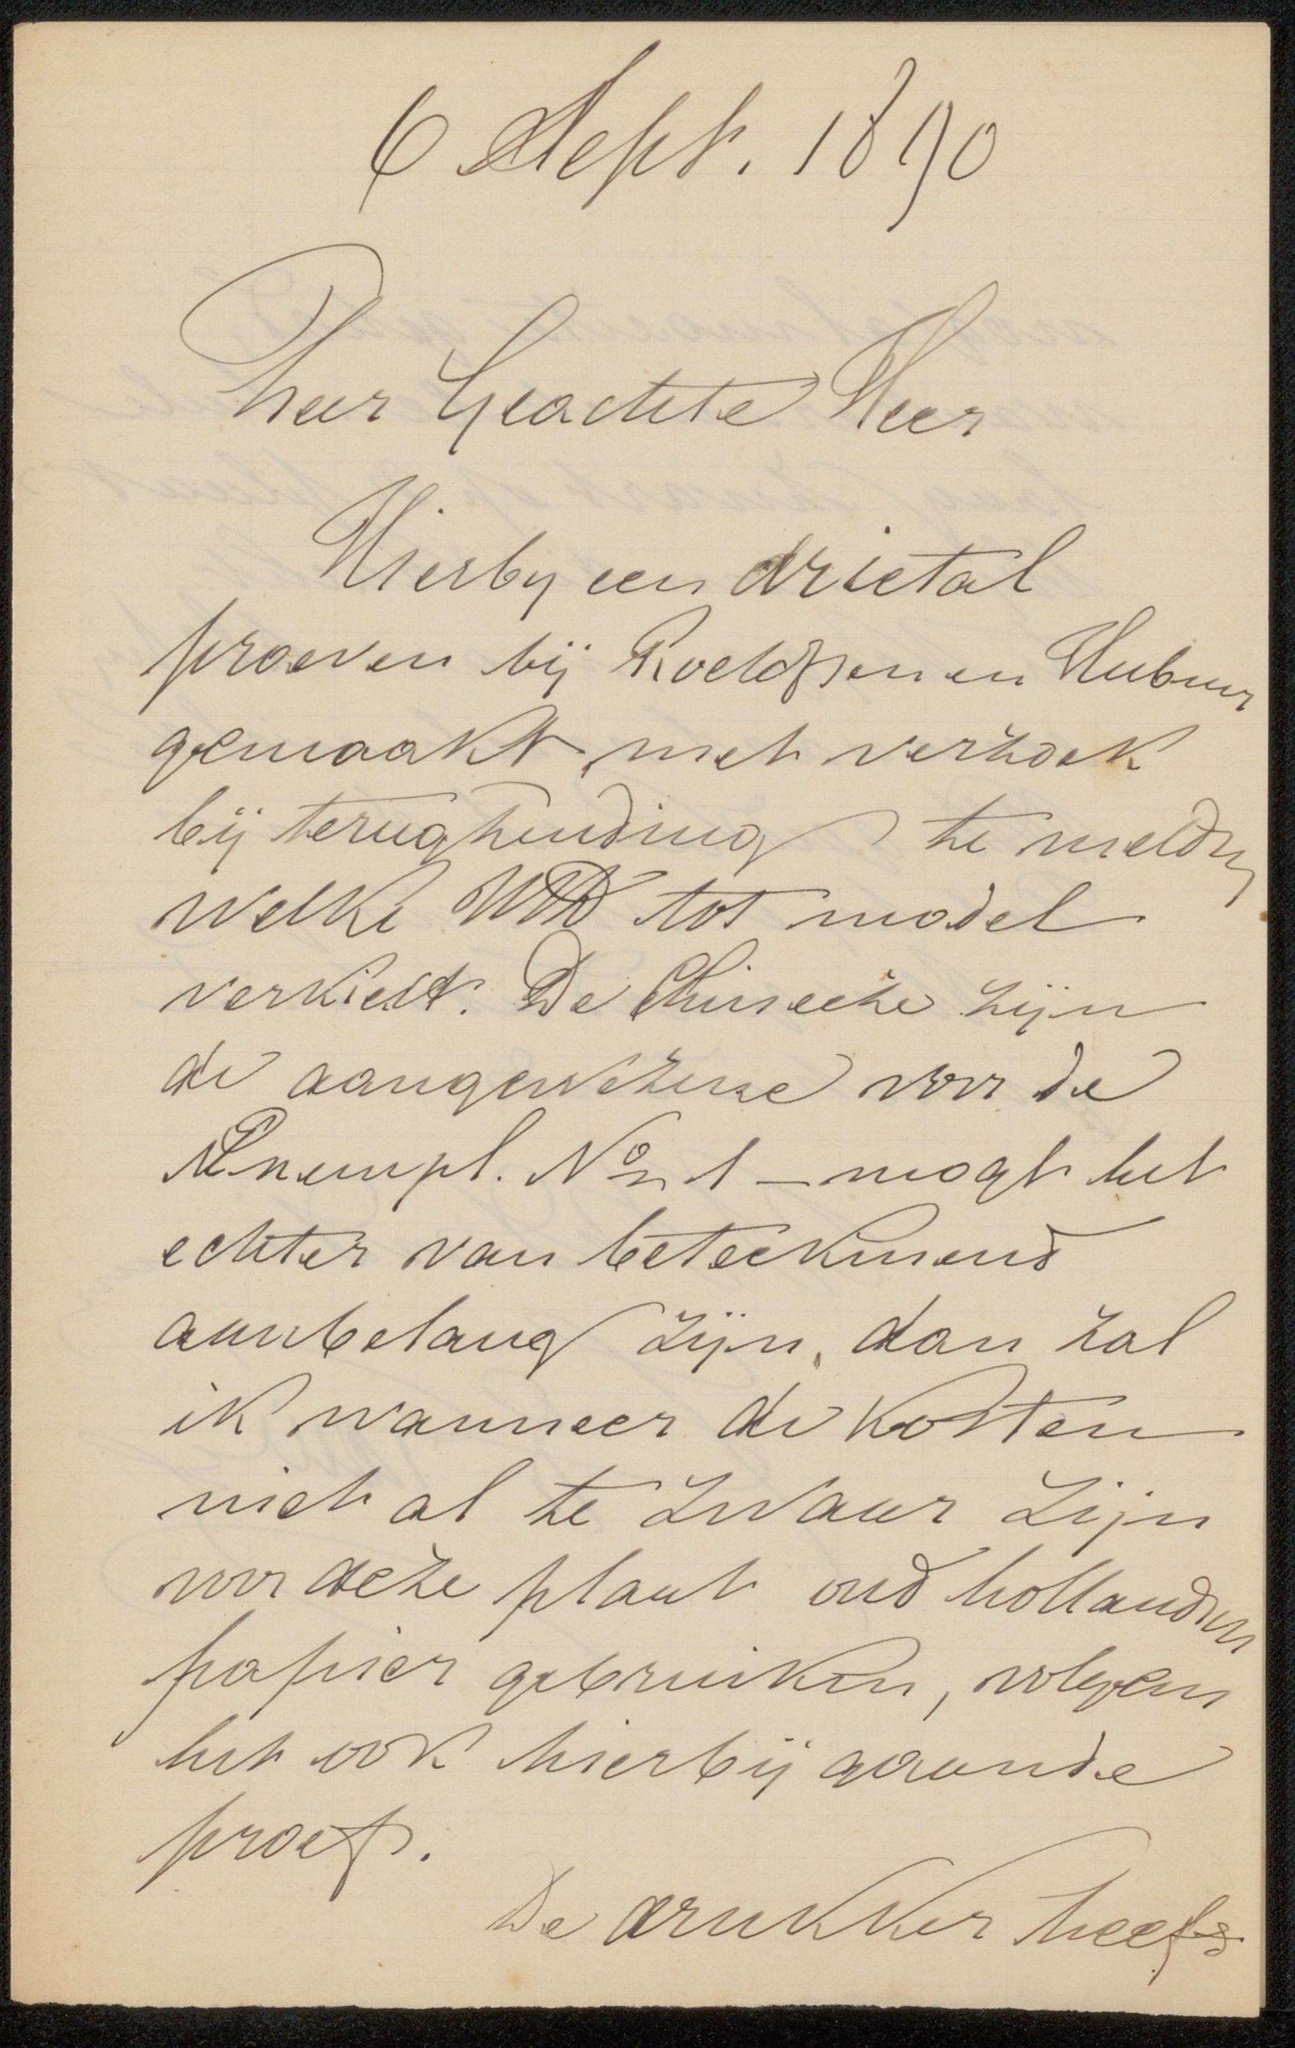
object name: letter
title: Brief aan Philip Zilcken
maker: edouard taurel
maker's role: draughtsman, print maker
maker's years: 1824-1892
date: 1890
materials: ink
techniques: pen, writing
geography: amsterdam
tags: the hague, painter, philip zilcken, printed matter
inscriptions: collector's mark: ‘RPK’